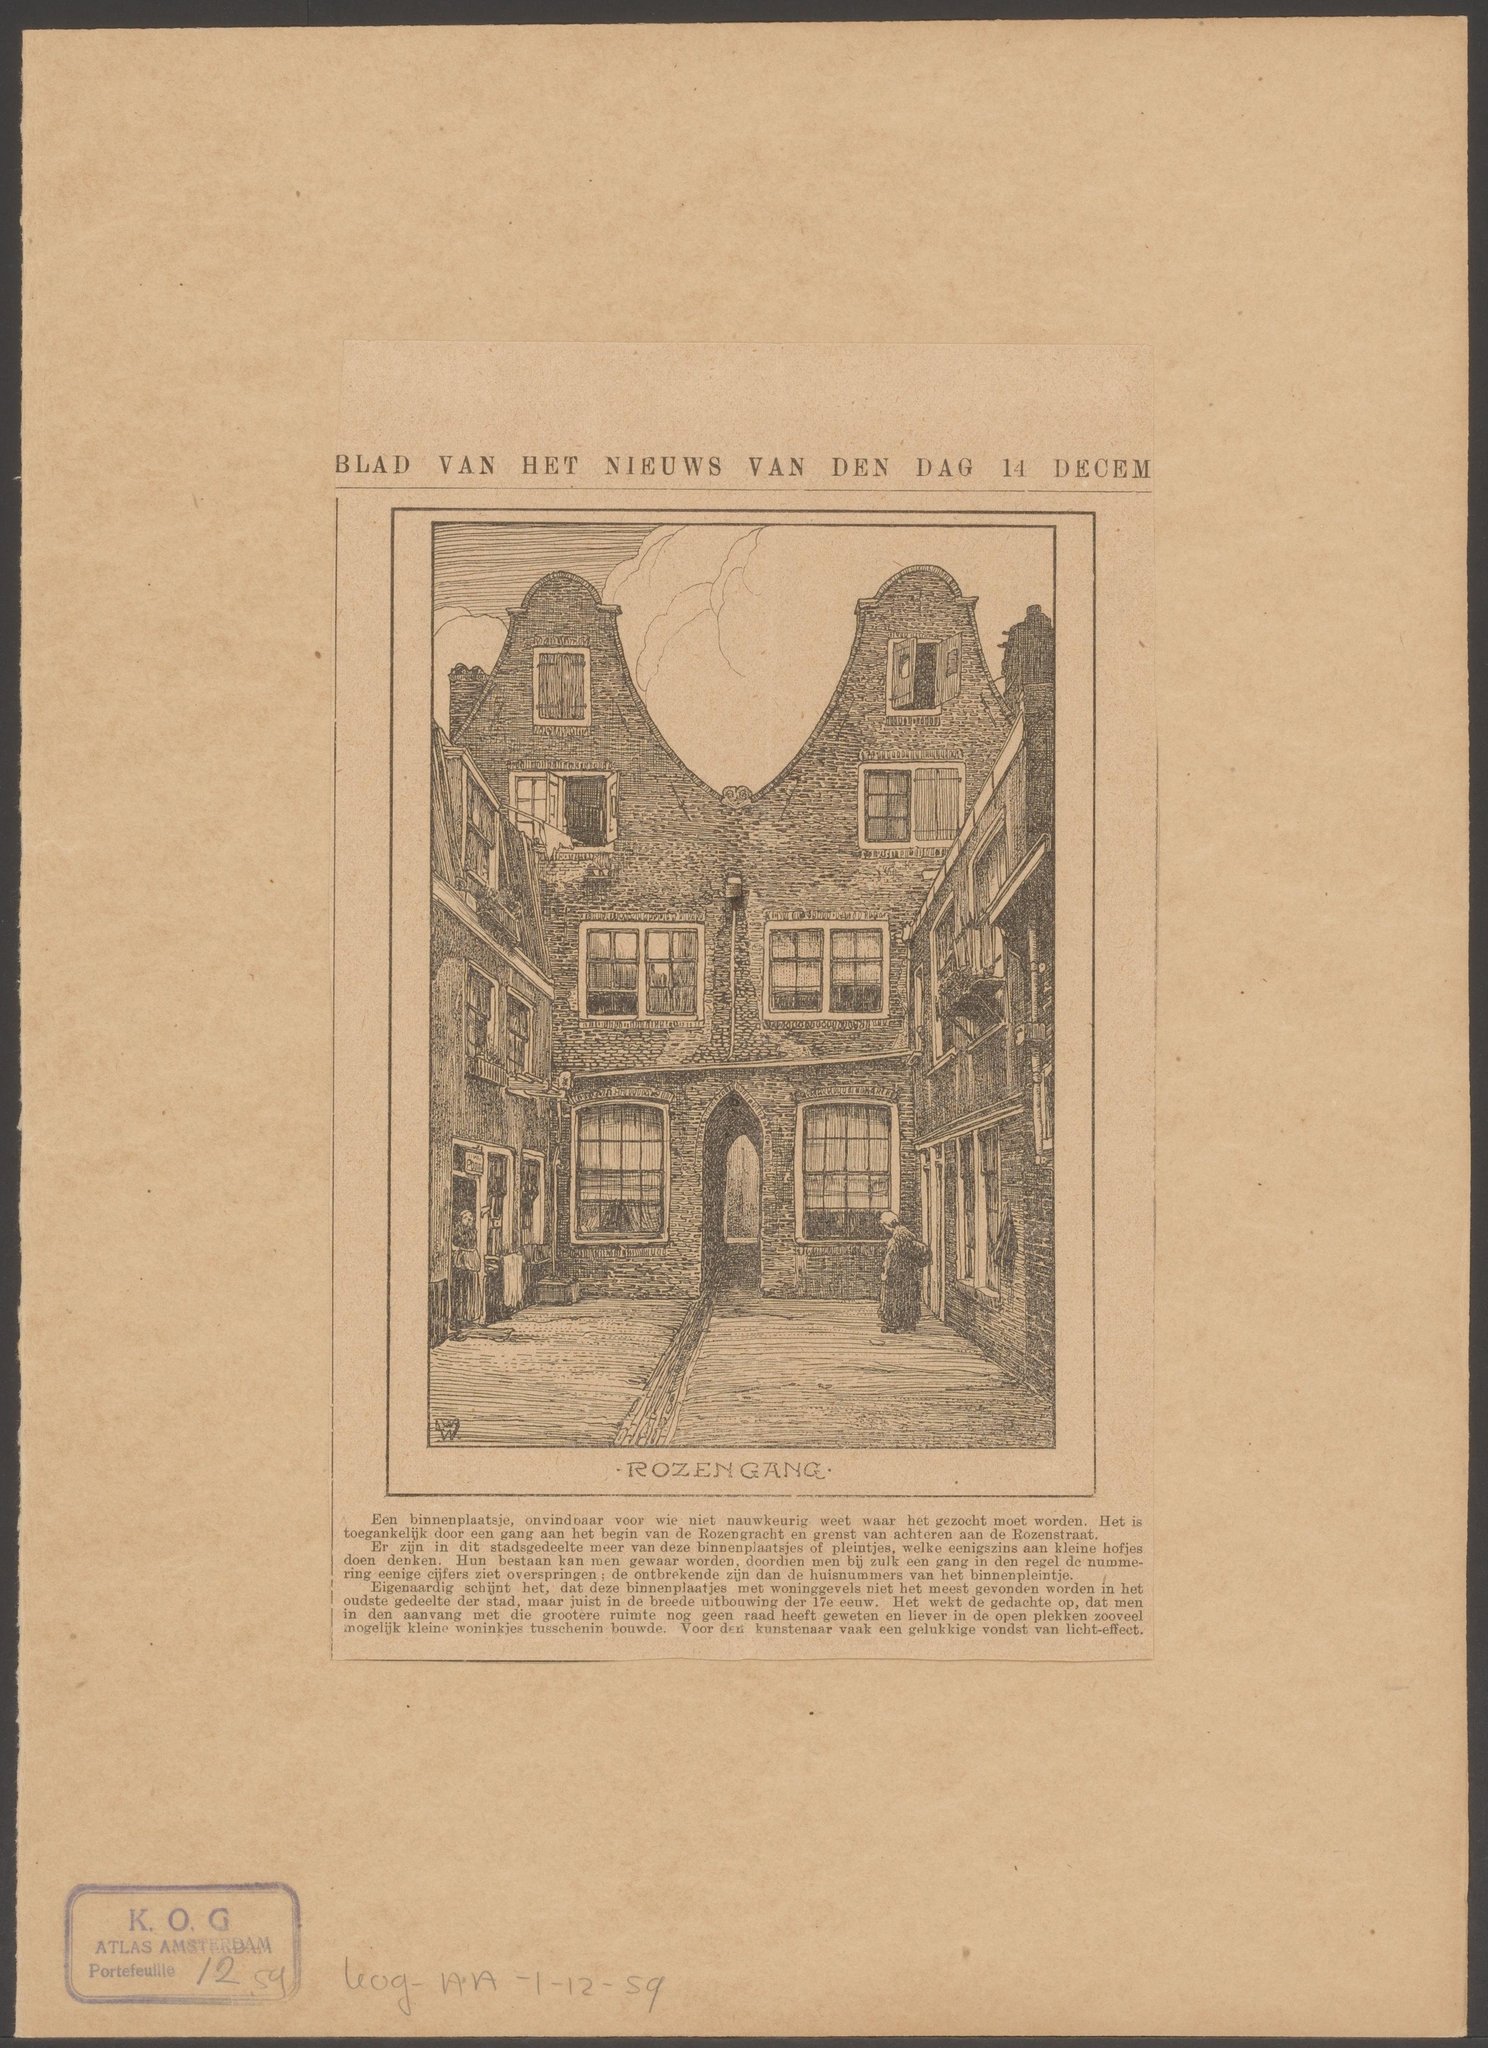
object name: photomechanical print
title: Oud-Amsterdam 100 Stadsgezichten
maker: willem wenckebach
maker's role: designer, draughtsman, painter, print maker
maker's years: 1860-1937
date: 1870-1923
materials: paper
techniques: letterpress printing, line block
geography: amsterdam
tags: city-view in general; 'veduta', gate, entrance, the usual house or row of houses, lane, alley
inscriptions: collector's mark: ‘12,59’ Lugt 1641b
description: Onderwerpsrubriek binnen de Atlas Amsterdam: Rokin, Rotterdammersloot, Rozengang, Rozengracht, Rozenstraat, Rusland, Rustenburgerstraat, Ruysdaelkade, Ruysdaelstraat, Ruyterkade (de), Ruyterweg (Admiraal de).